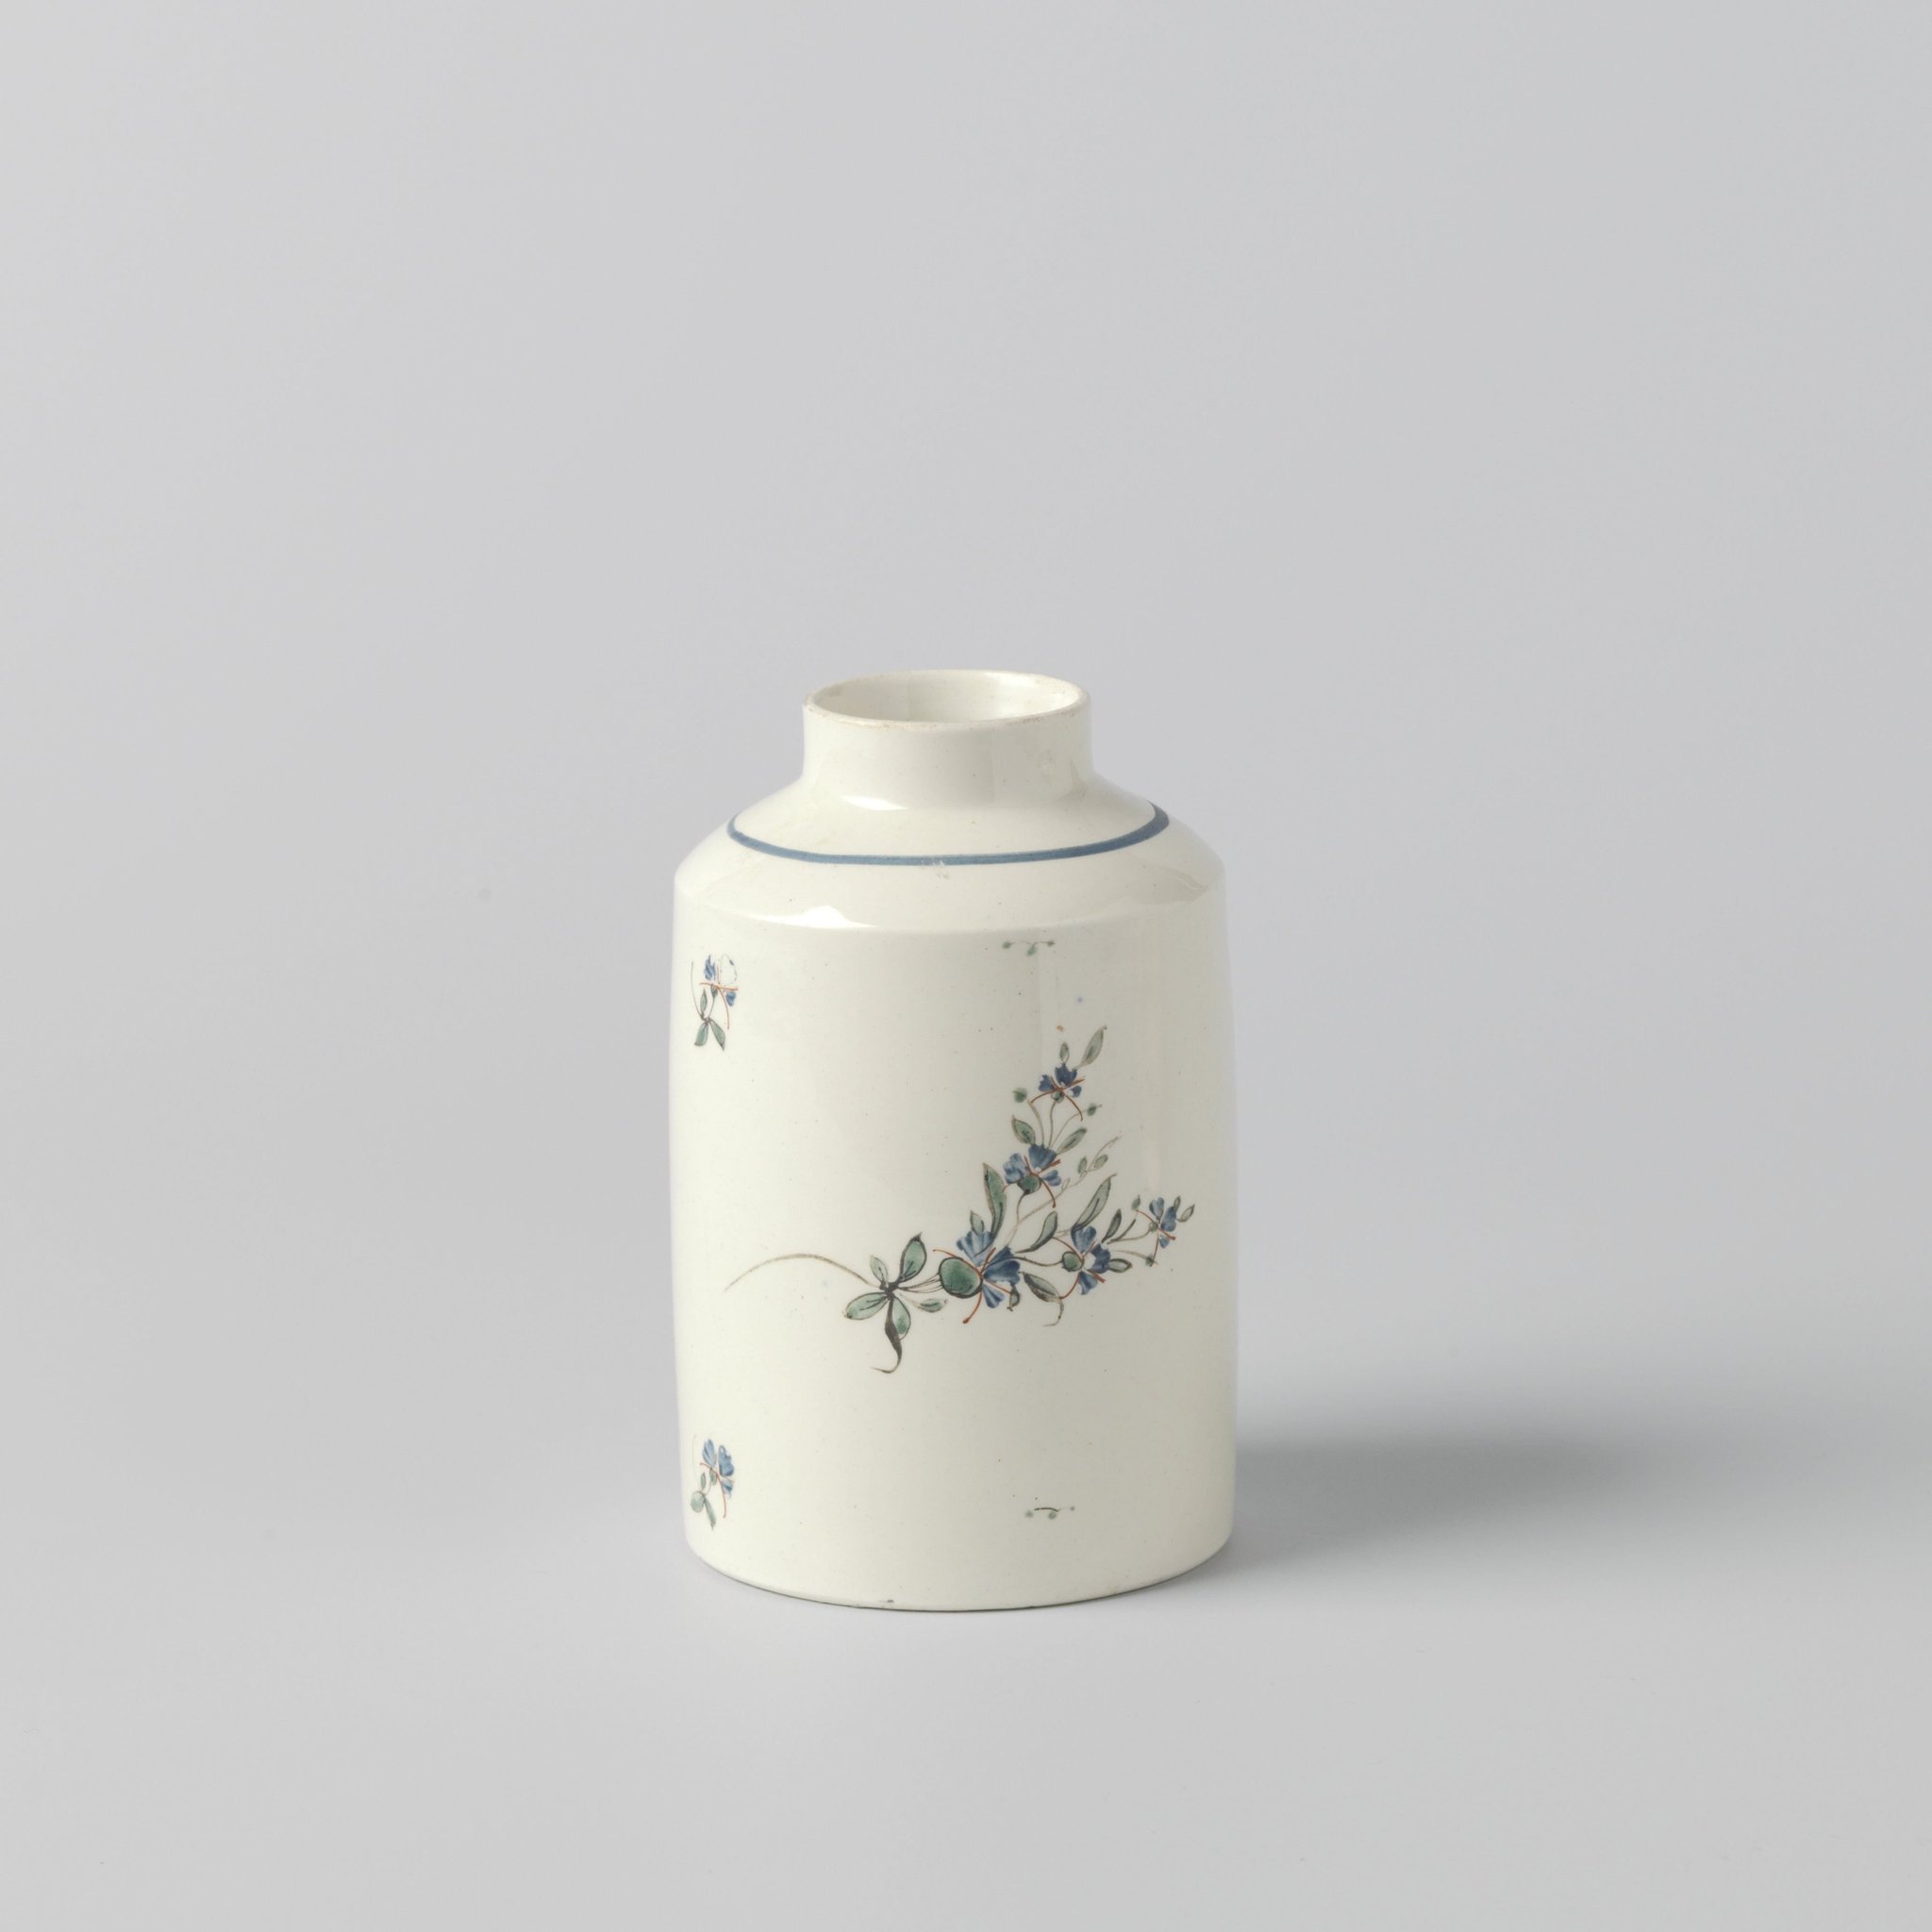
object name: bus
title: Theebus van hardgebakken aardewerk; Leeds creamware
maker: Anonymous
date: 1775-1790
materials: earthenware, glaze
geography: leeds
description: Cilindrische theebus van hardgebakken aardewerk met een decoratie op de glazuur. De decoratie bestaat uit bloemtakken in blauw, groen en rood. Het deksel ontbreekt. Bij de theebus hoort een suikerpot.